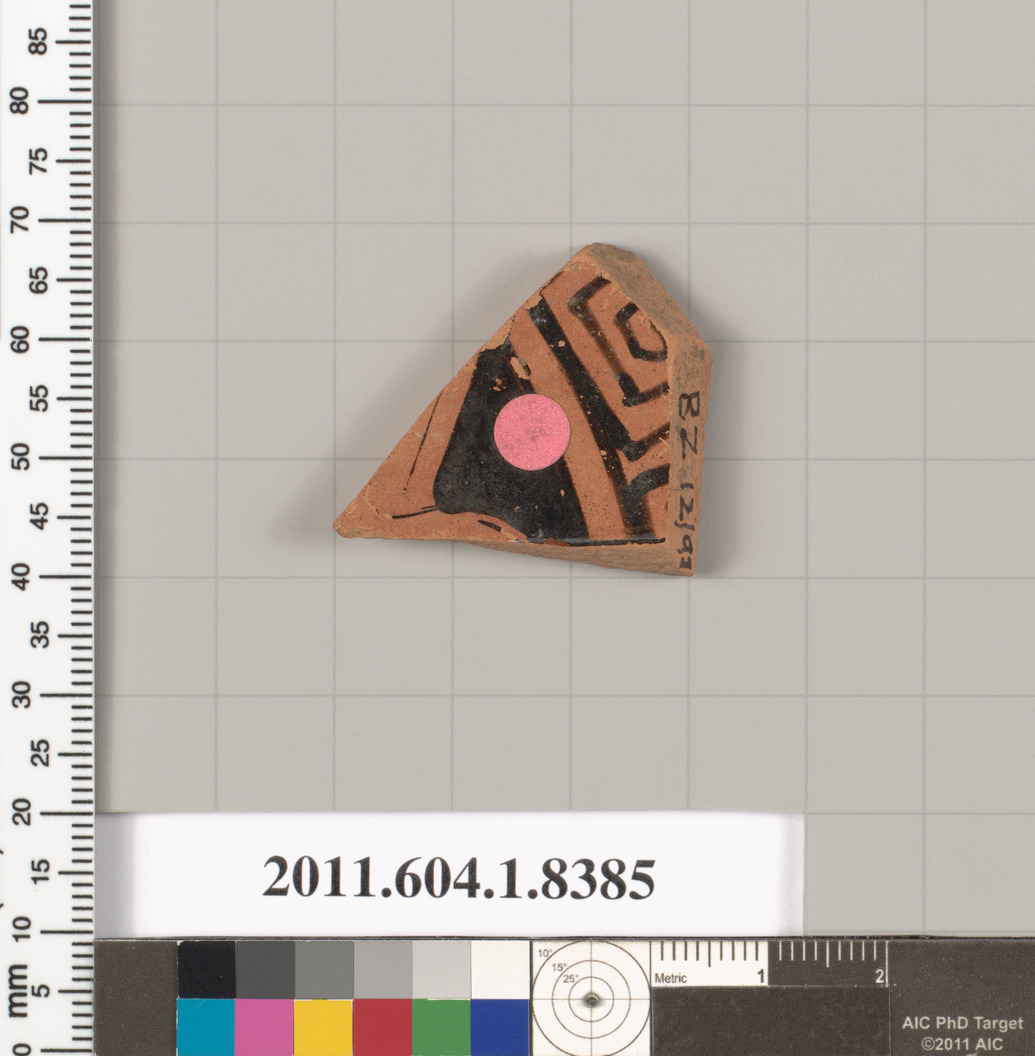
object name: kylix fragment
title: Terracotta fragment of a kylix (drinking cup)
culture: greek, attic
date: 400-351 BCE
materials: terracotta